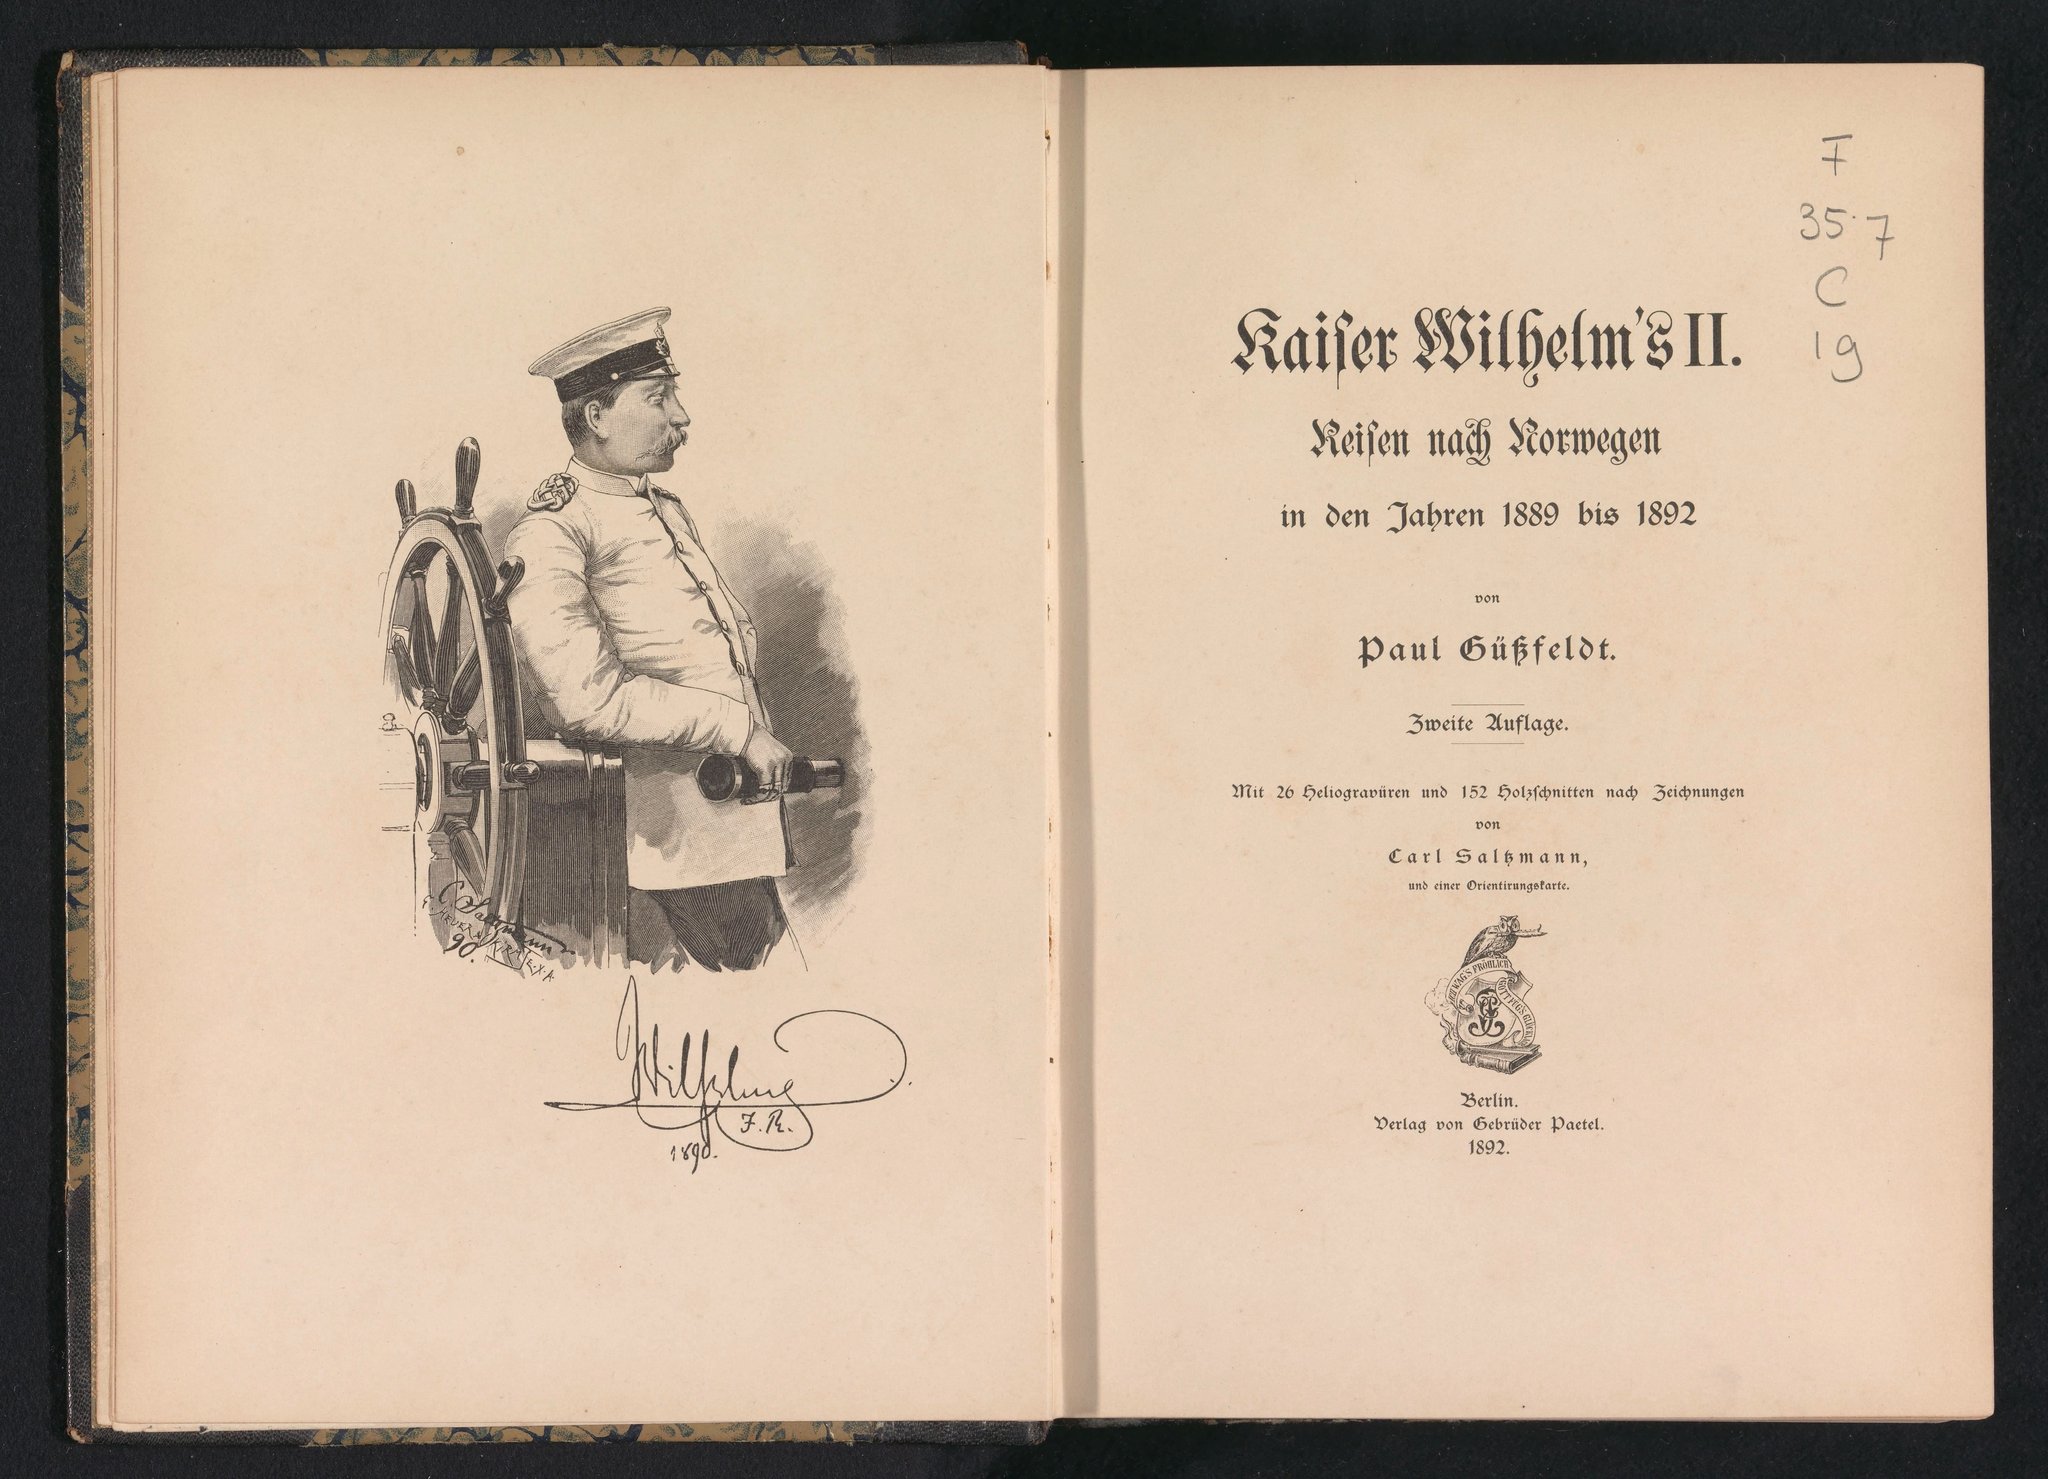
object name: book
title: Kaiser Wilhelm's II. Reisen nach Norwegen in den Jahren 1889 bis 1892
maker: paul güssfeldt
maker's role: alpinist, wiskundige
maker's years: 1840-1920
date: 1892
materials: cardboard, leather, paper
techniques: photoaquatint, printing, marbling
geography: berlin